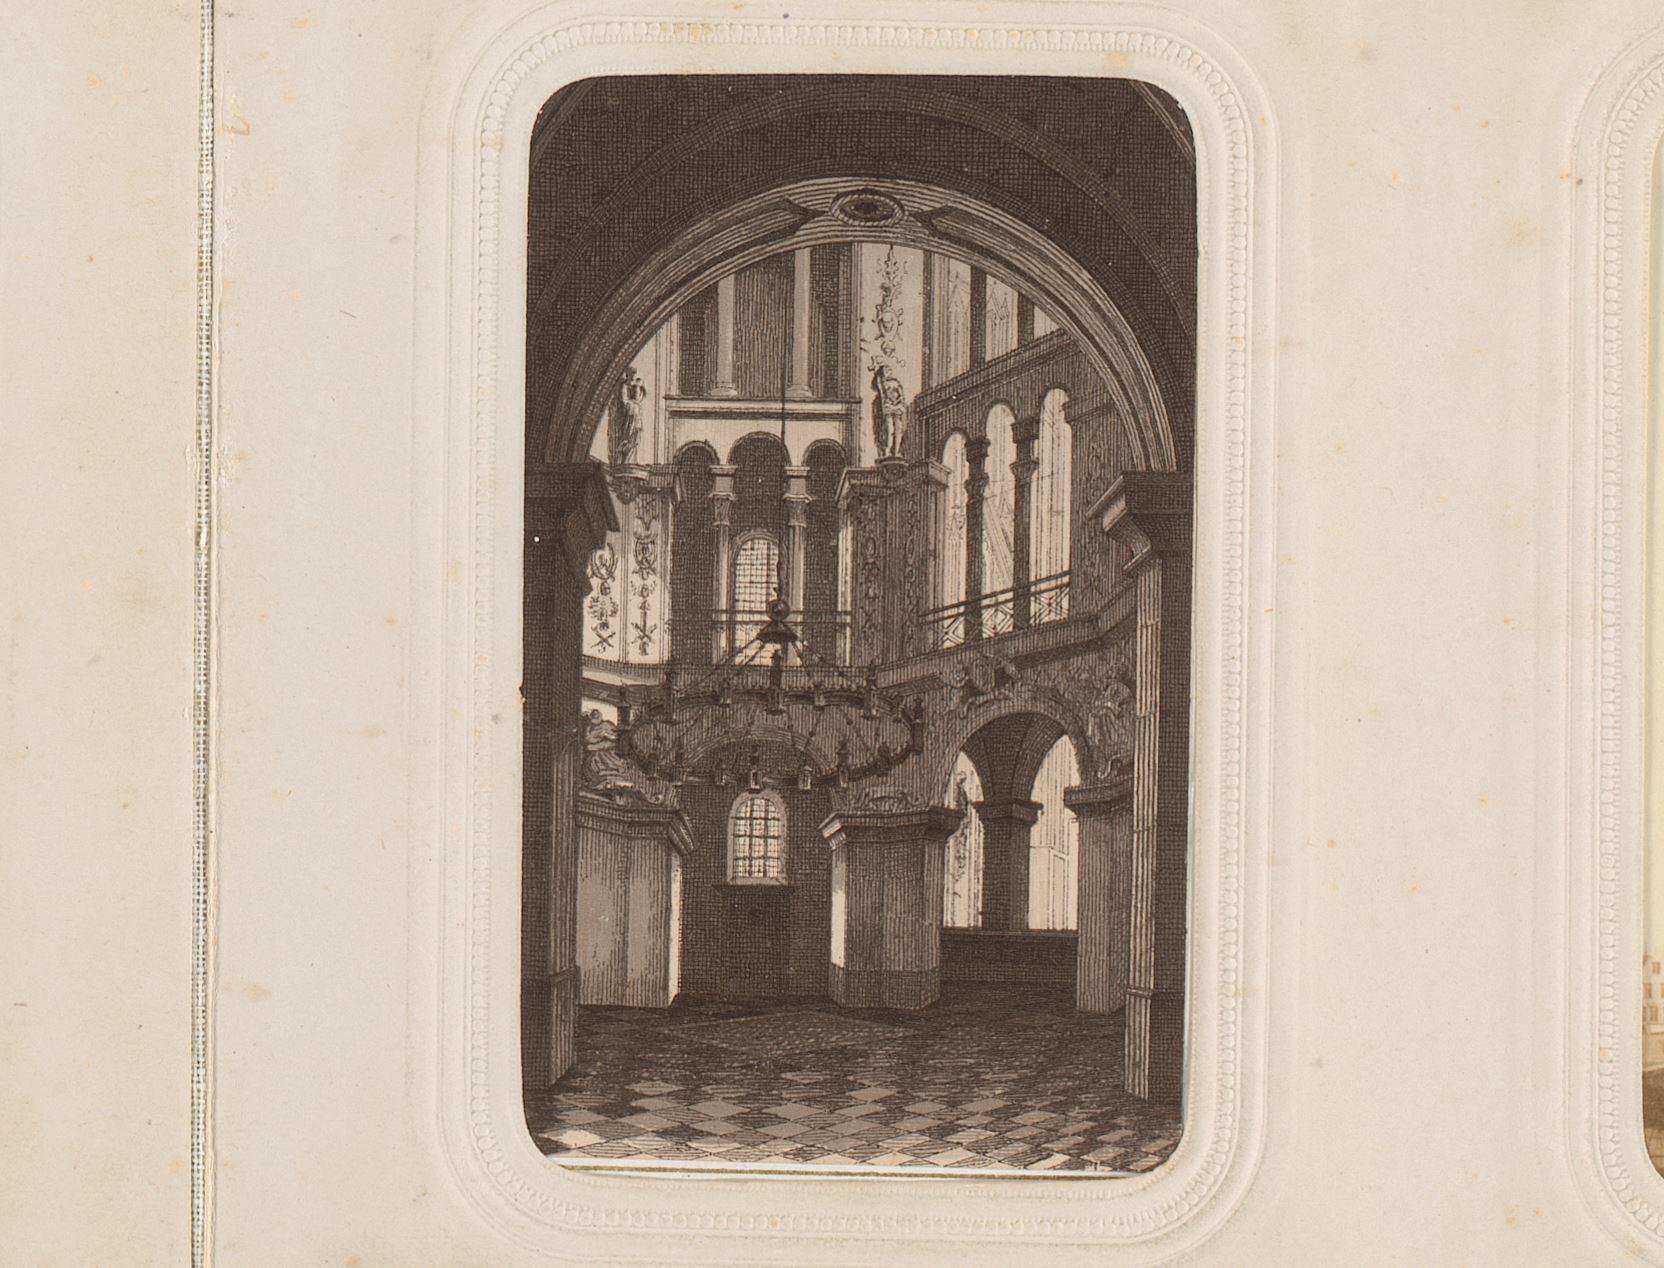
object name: reproduction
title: Fotoreproductie van een prent van het interieur van de Dom van Aken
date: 1860-1885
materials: cardboard, photographic support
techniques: collodion silver print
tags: interior of church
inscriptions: annotation: ‘Innere des Doms’, annotation: ‘Innere/ des Doms/ Aken’